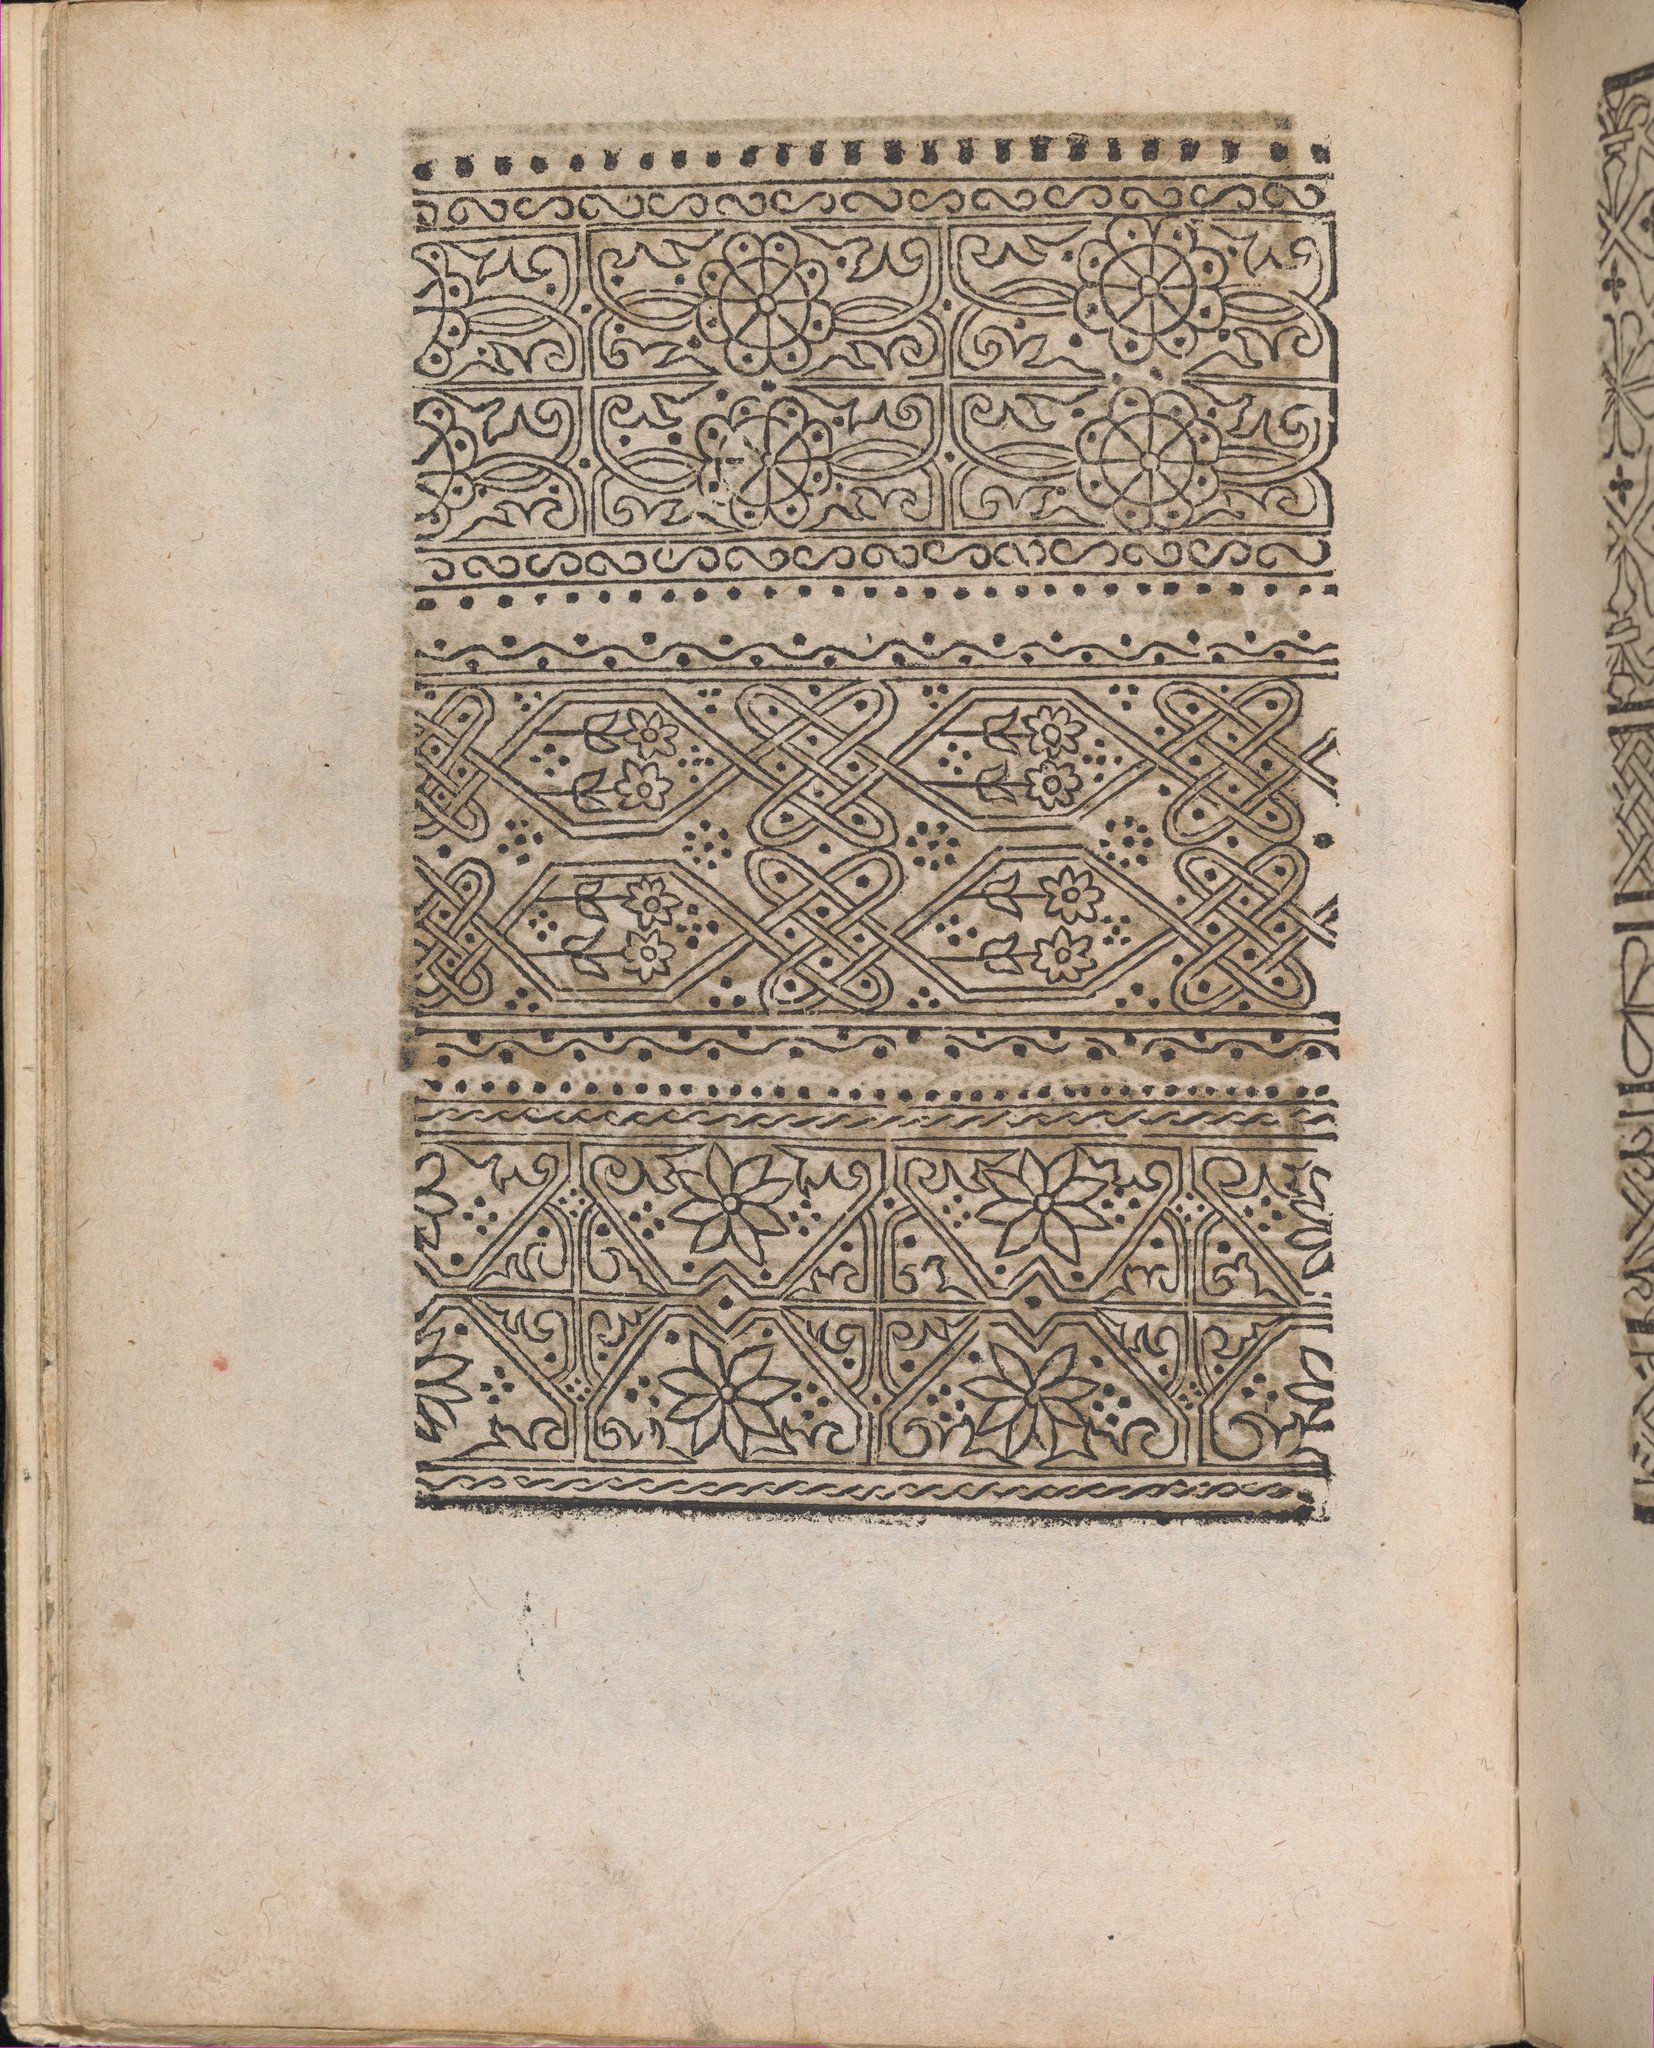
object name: book print ornament architecture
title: Modelbuch aller Art Nehens vn Stickens (Page 9v)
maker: christian egenolff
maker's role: publisher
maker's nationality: german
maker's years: 1502-1555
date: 1535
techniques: woodcut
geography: germany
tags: ornament